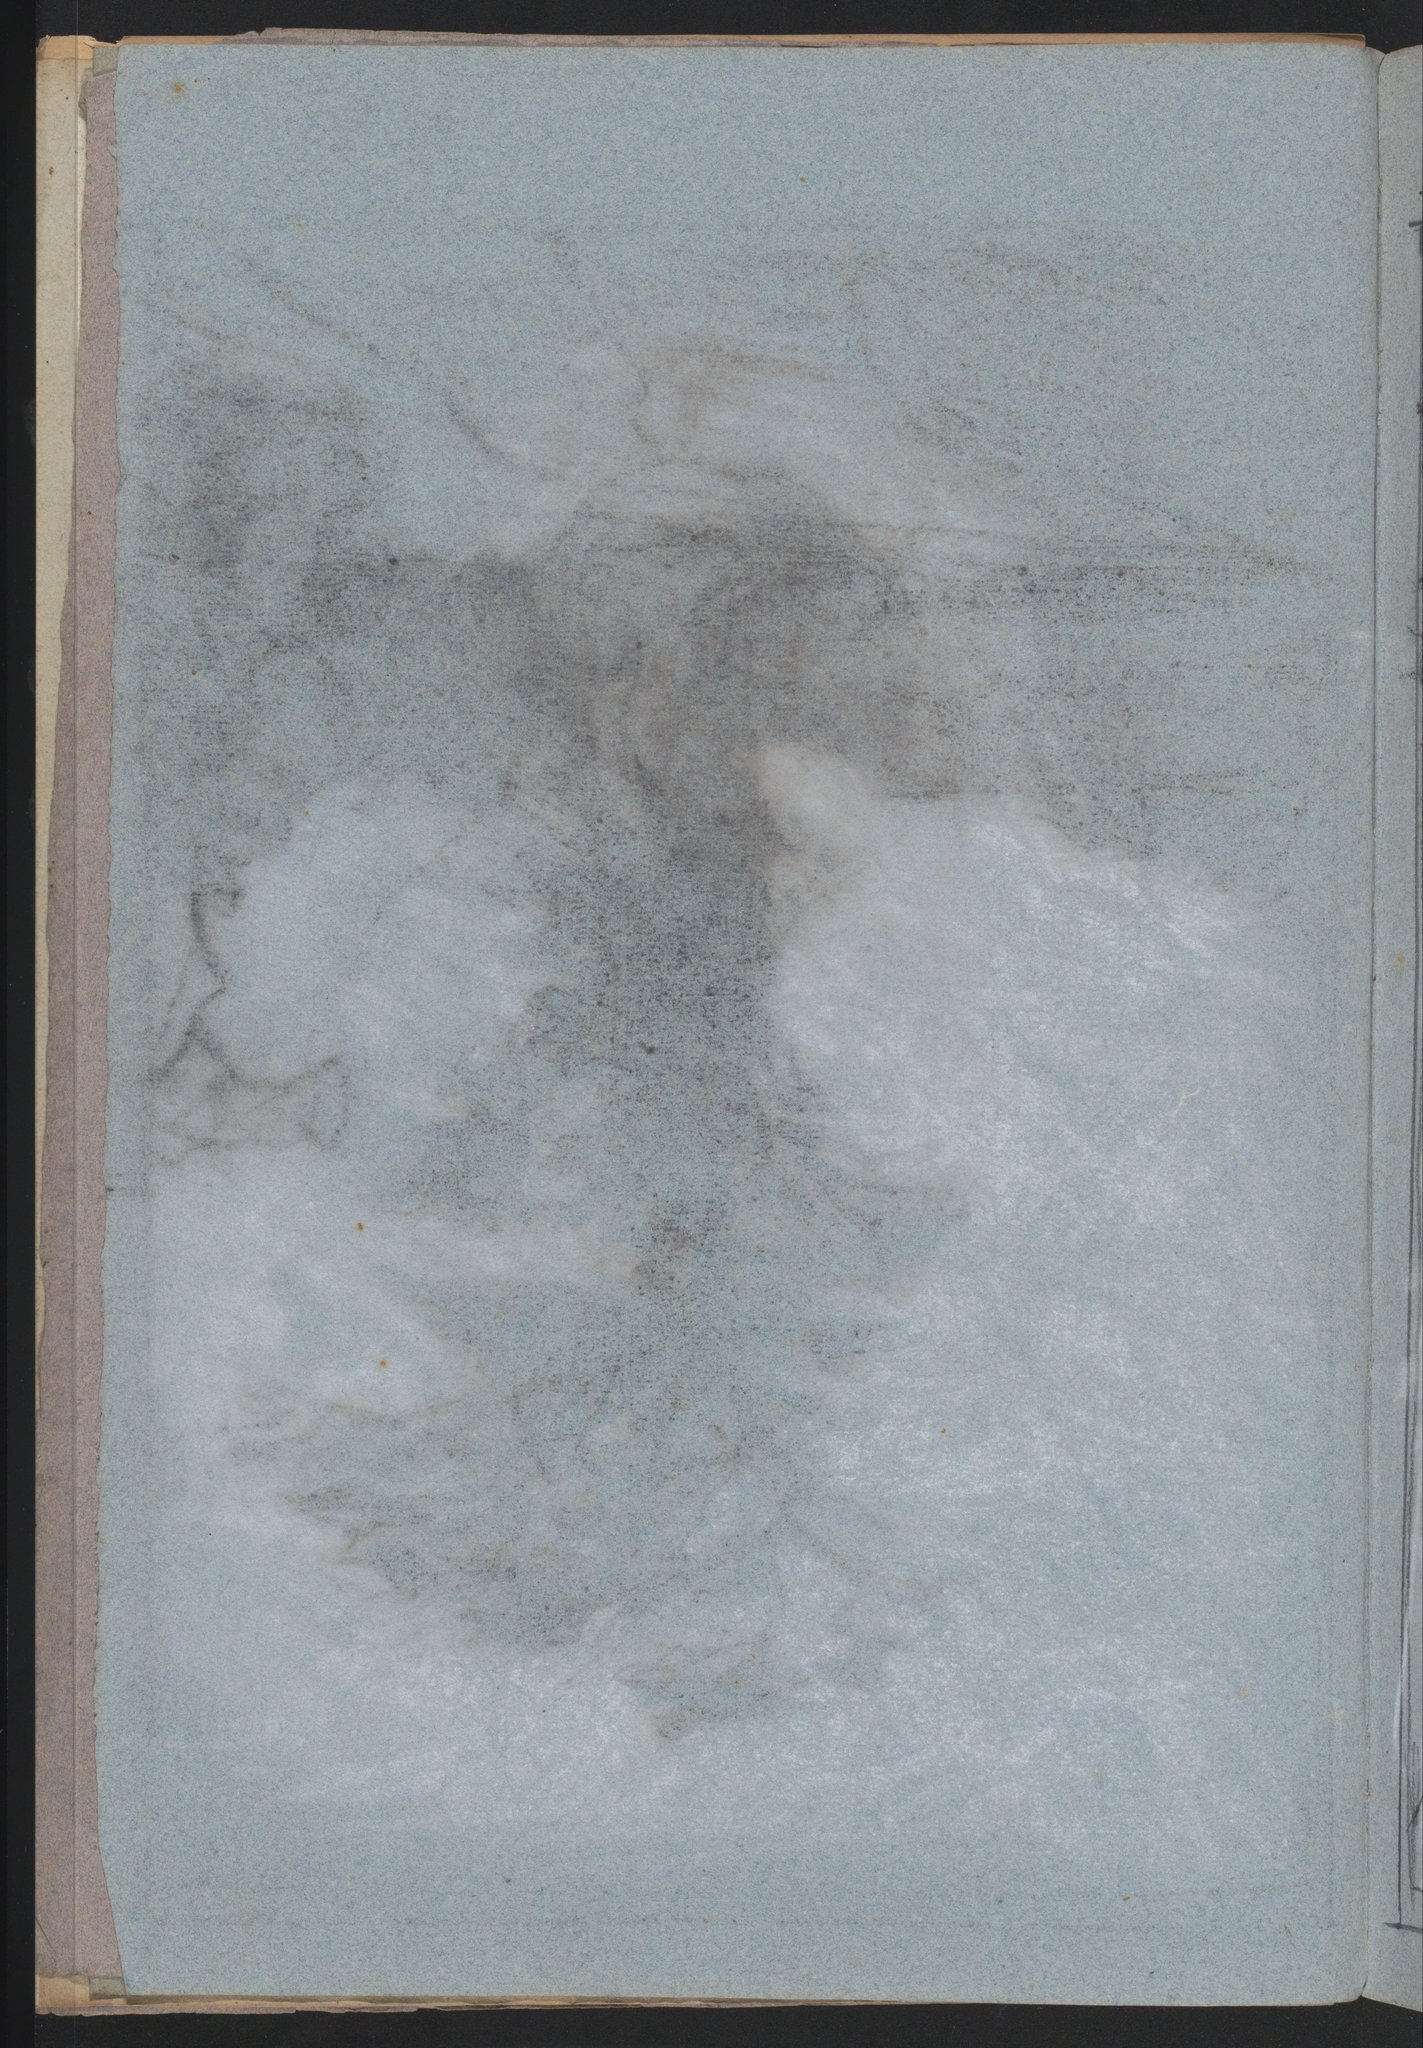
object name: sketchbook leaf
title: Abklatsch van de krijttekening op pagina 18 recto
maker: jan veth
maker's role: designer, draughtsman, painter, print maker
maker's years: 1864-1925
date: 1874-1925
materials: paper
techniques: printmaking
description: Blad 17 verso uit een schetsboek met 42 bladen.